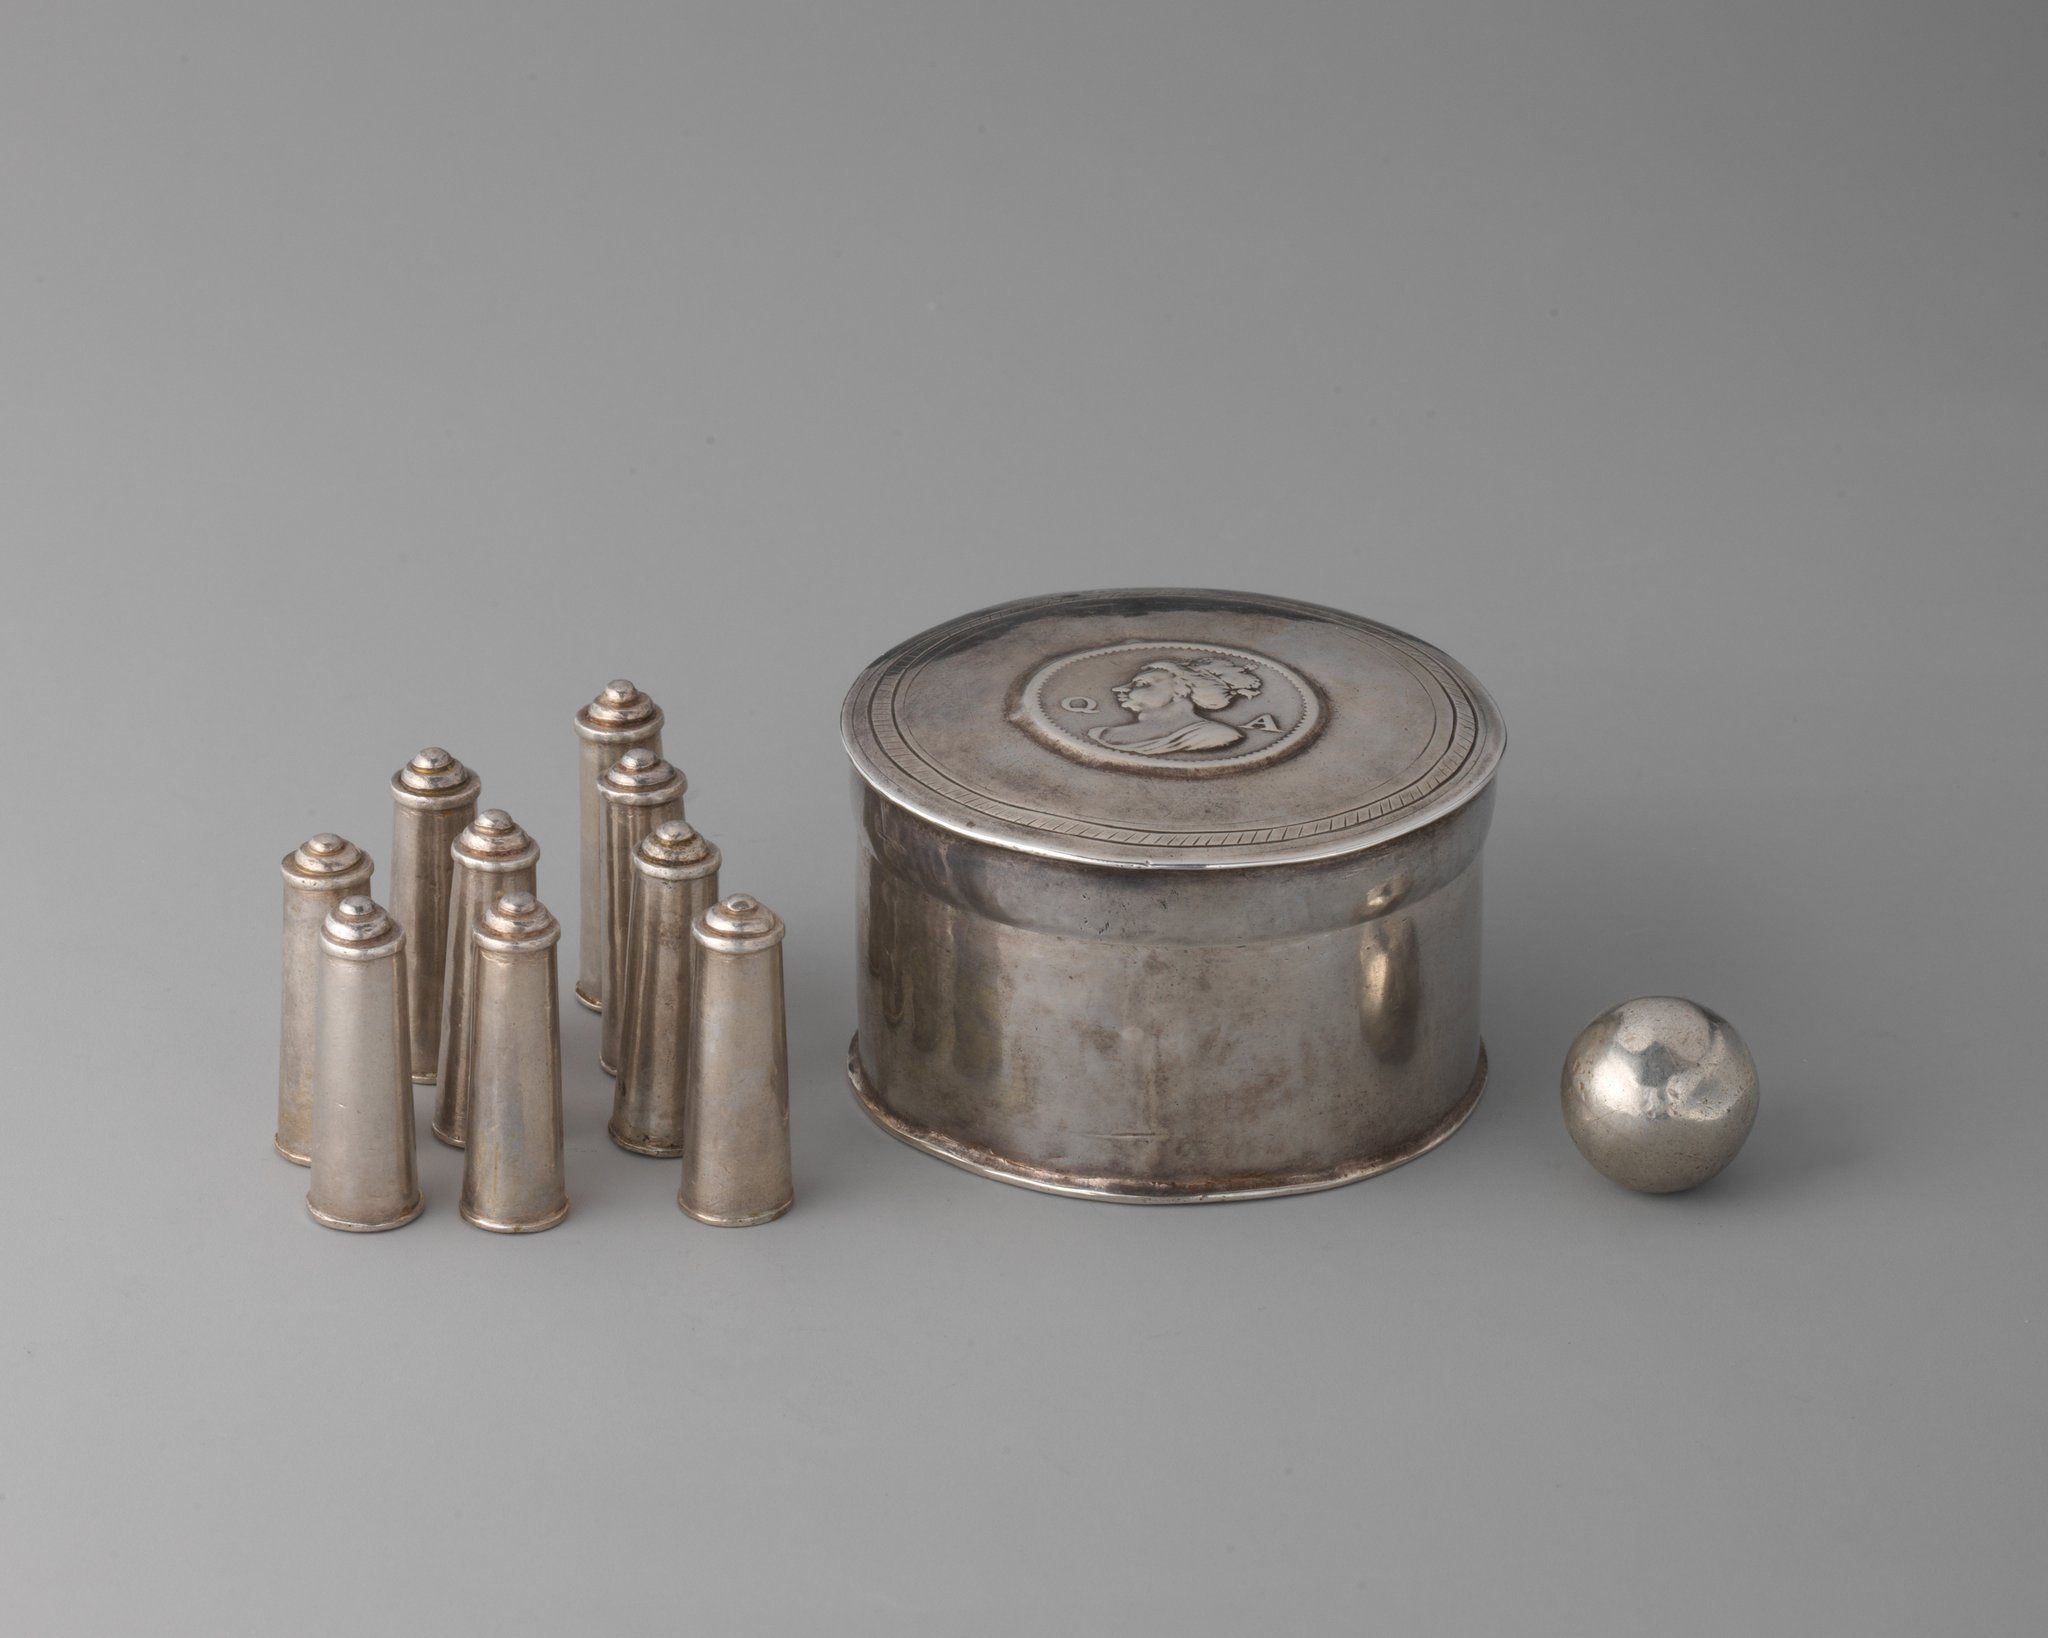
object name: pin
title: Miniature pins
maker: t.k., london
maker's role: maker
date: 1702-1714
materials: silver